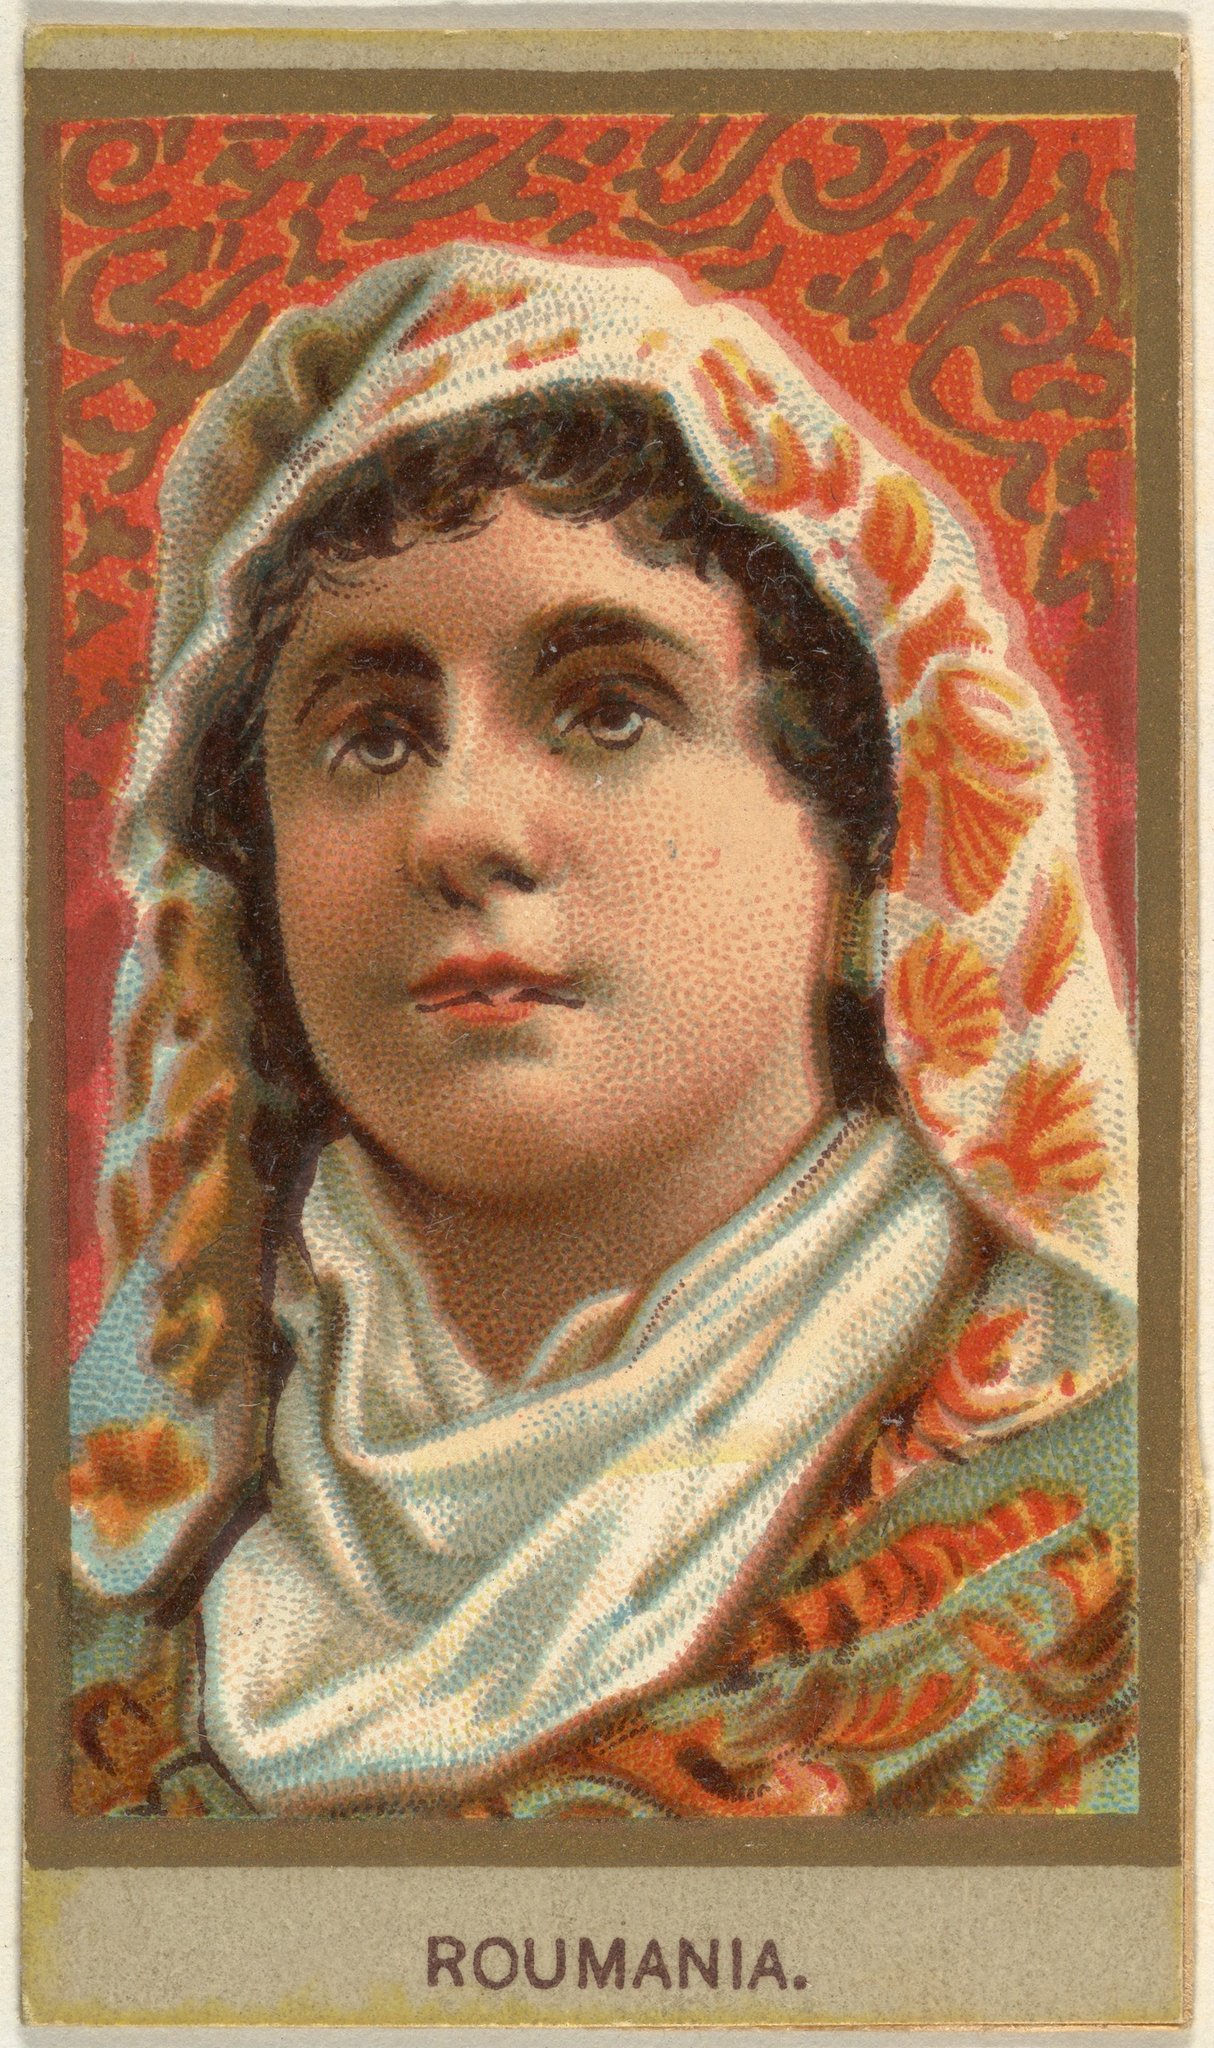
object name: print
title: Romania, from the Races of Mankind series (T181) issued by Abdul Cigarettes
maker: abdul cigarettes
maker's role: publisher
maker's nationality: american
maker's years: 1881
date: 1881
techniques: color lithograph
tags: women